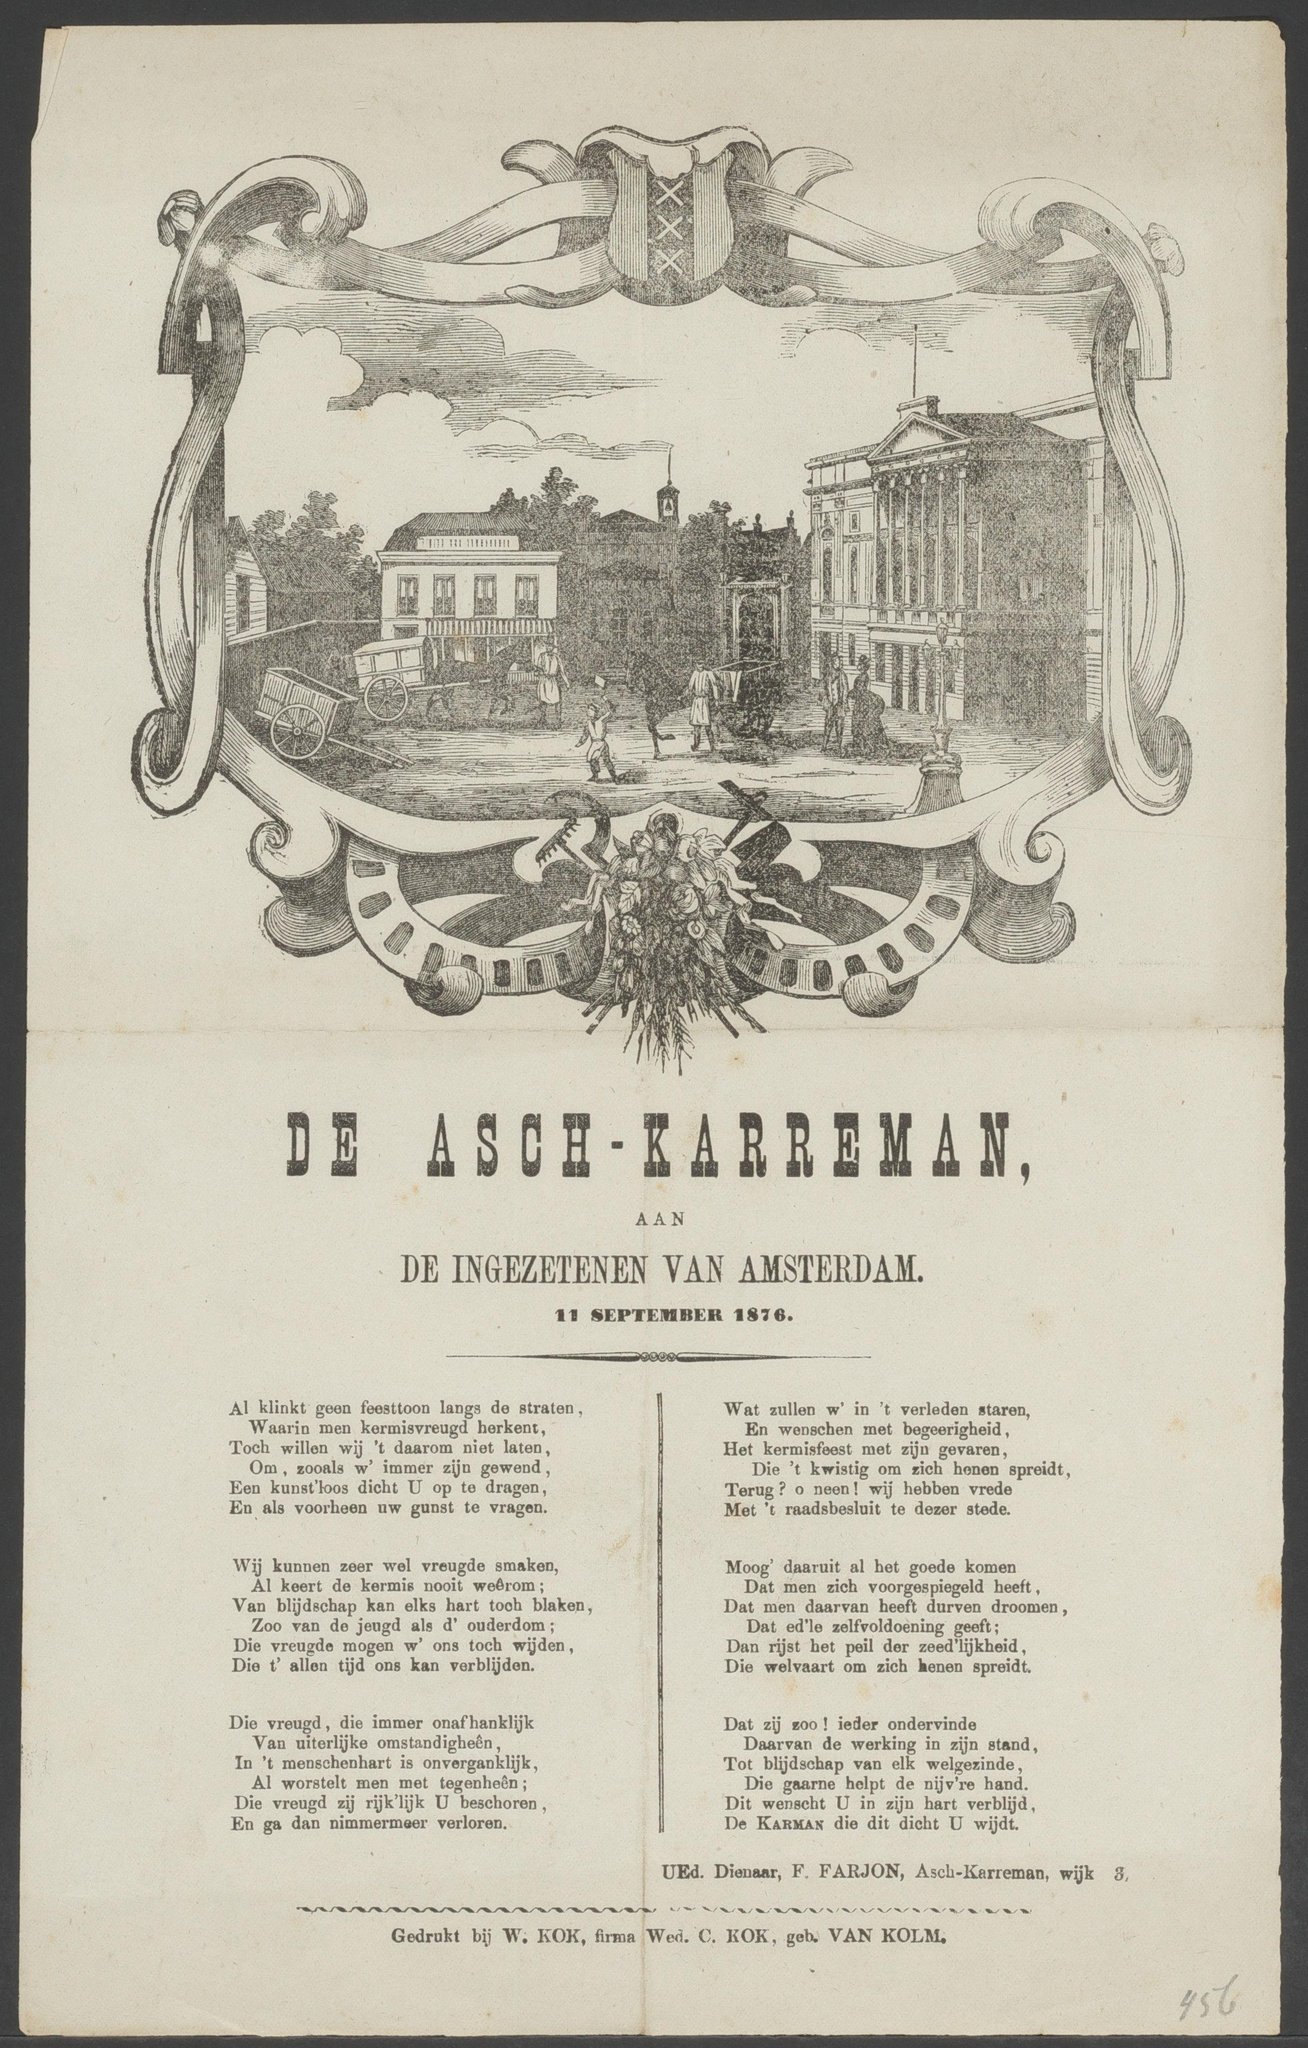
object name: print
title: Kermisprent van de Amsterdamse askarrenmannen voor het jaar 1876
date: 1876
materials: paper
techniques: letterpress printing, engraving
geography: amsterdam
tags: garbage collection, amsterdam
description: Kermisprent namens de askarrenmannen (karrenman of vuilnisman) te Amsterdam, 11 september 1876. Gezicht op een plein met vuilnismannen en drie vuilniskarren. Onderaan een gedicht in twee kolommen. Namens F. Fardon, de askarreman van wijk no. 8. Onderwerpsrubrieken binnen de Atlas Zeden en Gewoonten: Zeden en gewoonten in engeren zin, Volksleven, Volksbladen, Nieuwjaars- en Kerstwenschen, Amsterdam.